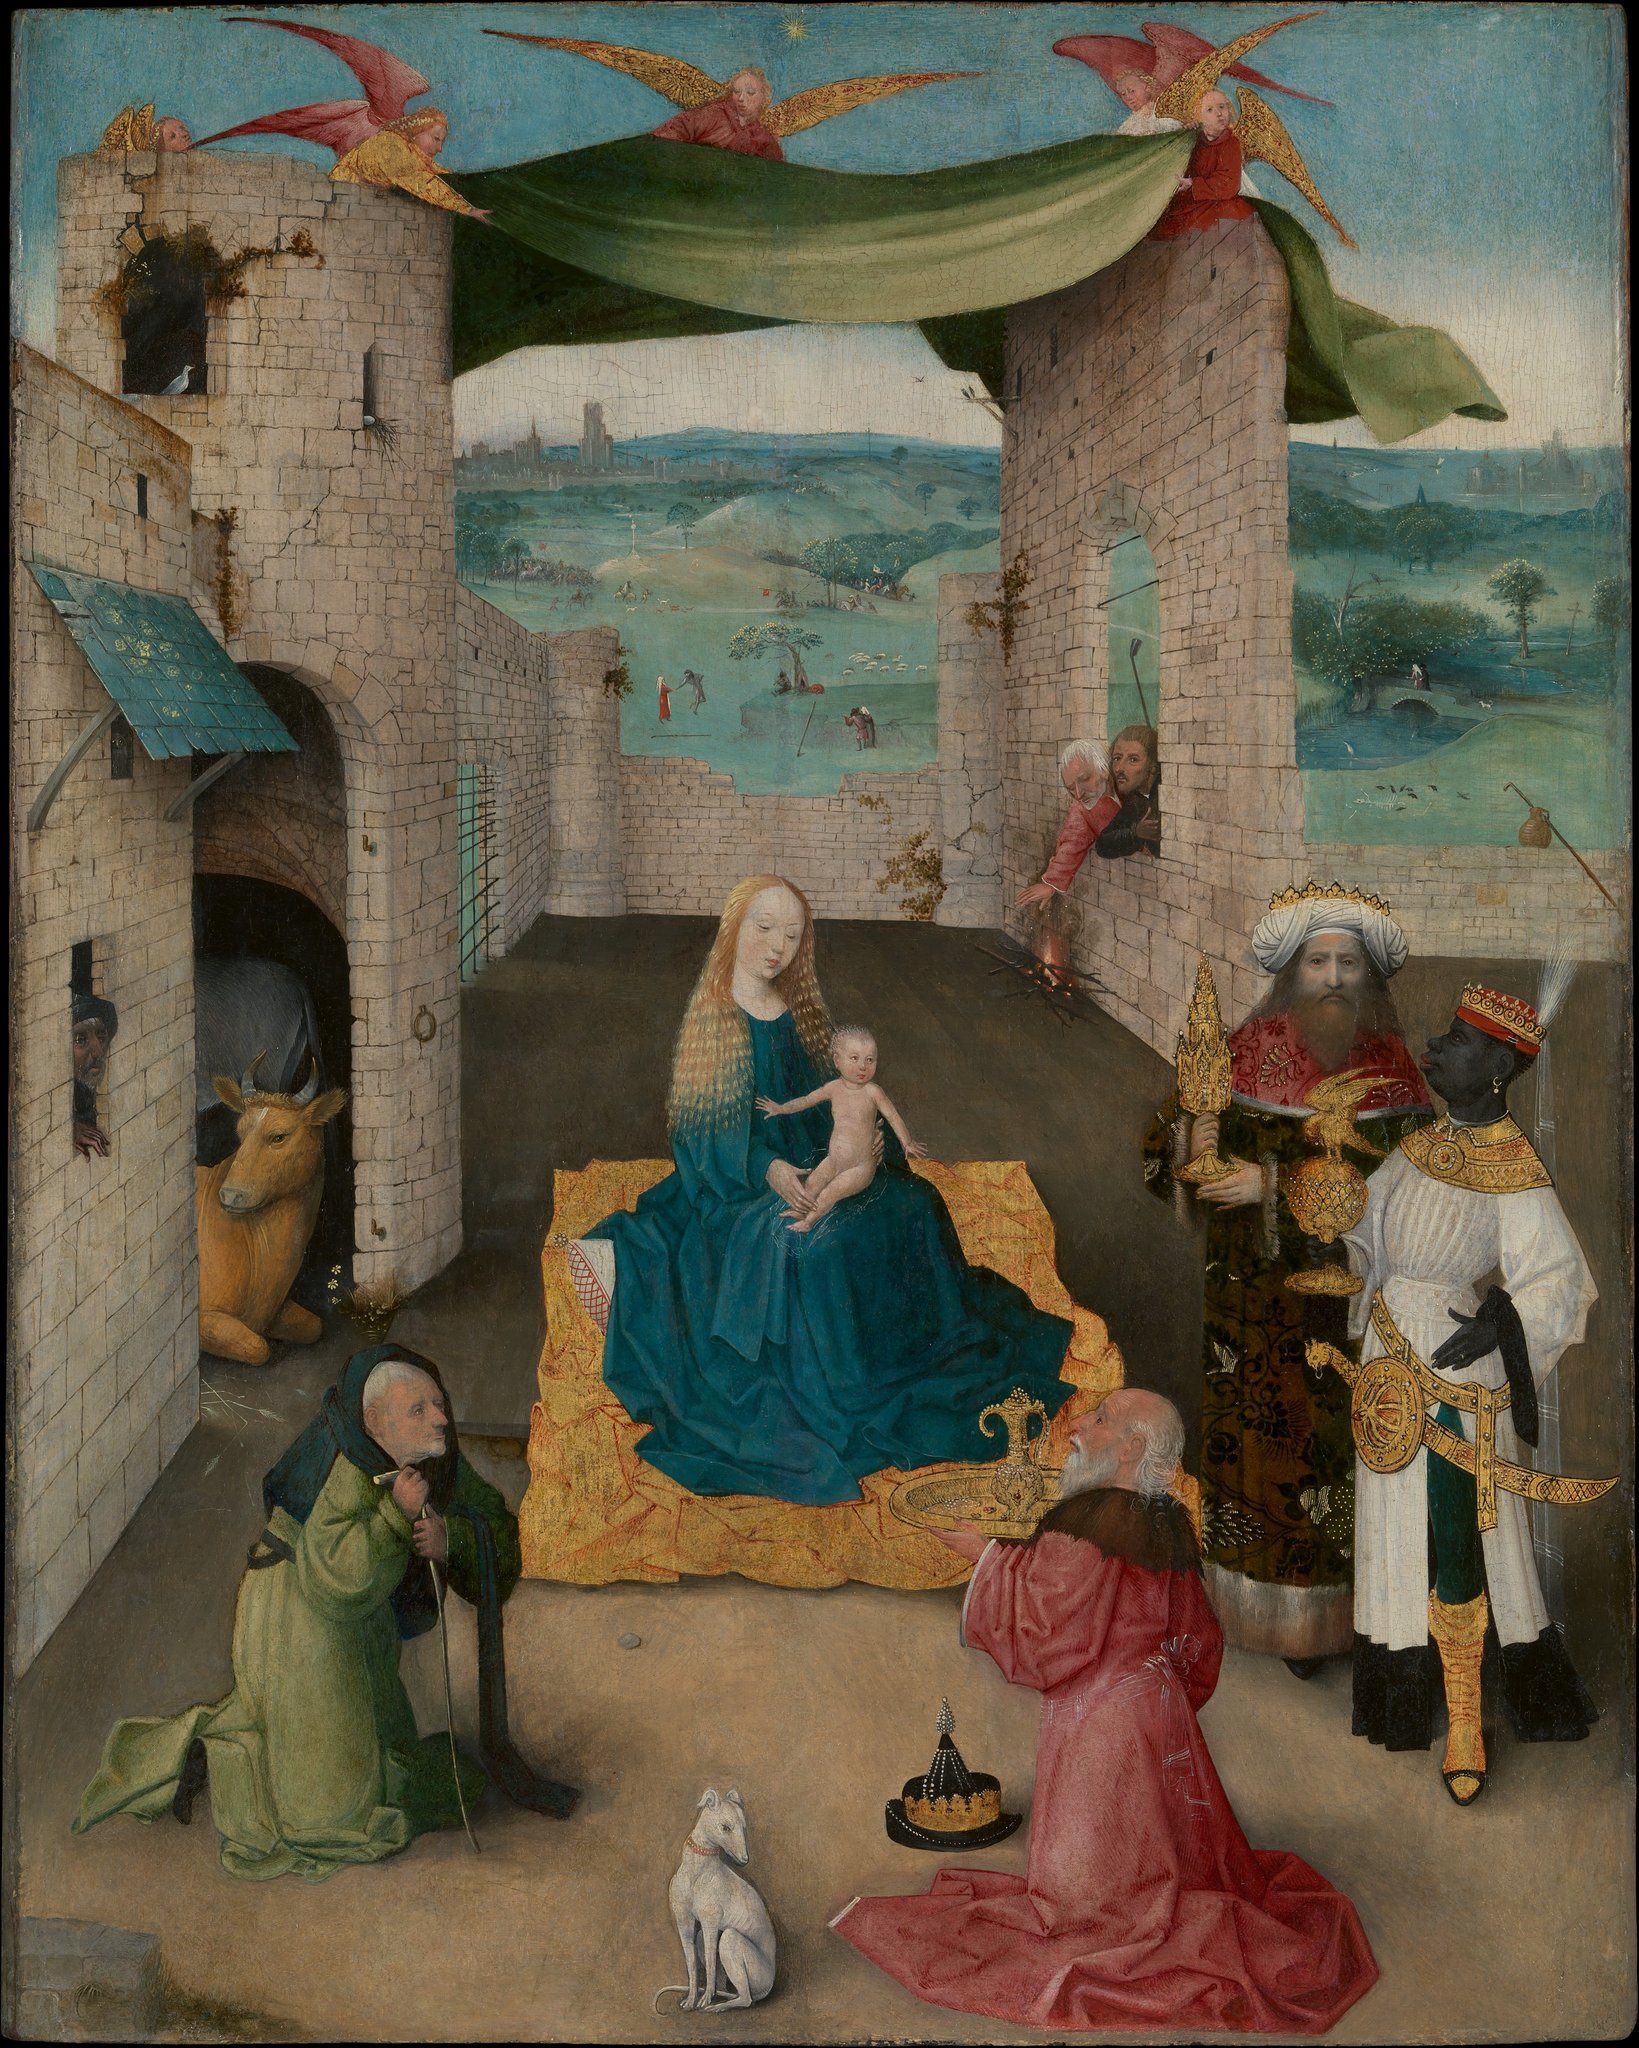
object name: painting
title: The Adoration of the Magi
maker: hieronymus bosch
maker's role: artist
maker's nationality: netherlandish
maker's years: 1450-1516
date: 1475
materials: gold, wood, oil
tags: cows,dogs,angels,virgin mary,jesus,adoration of the magi